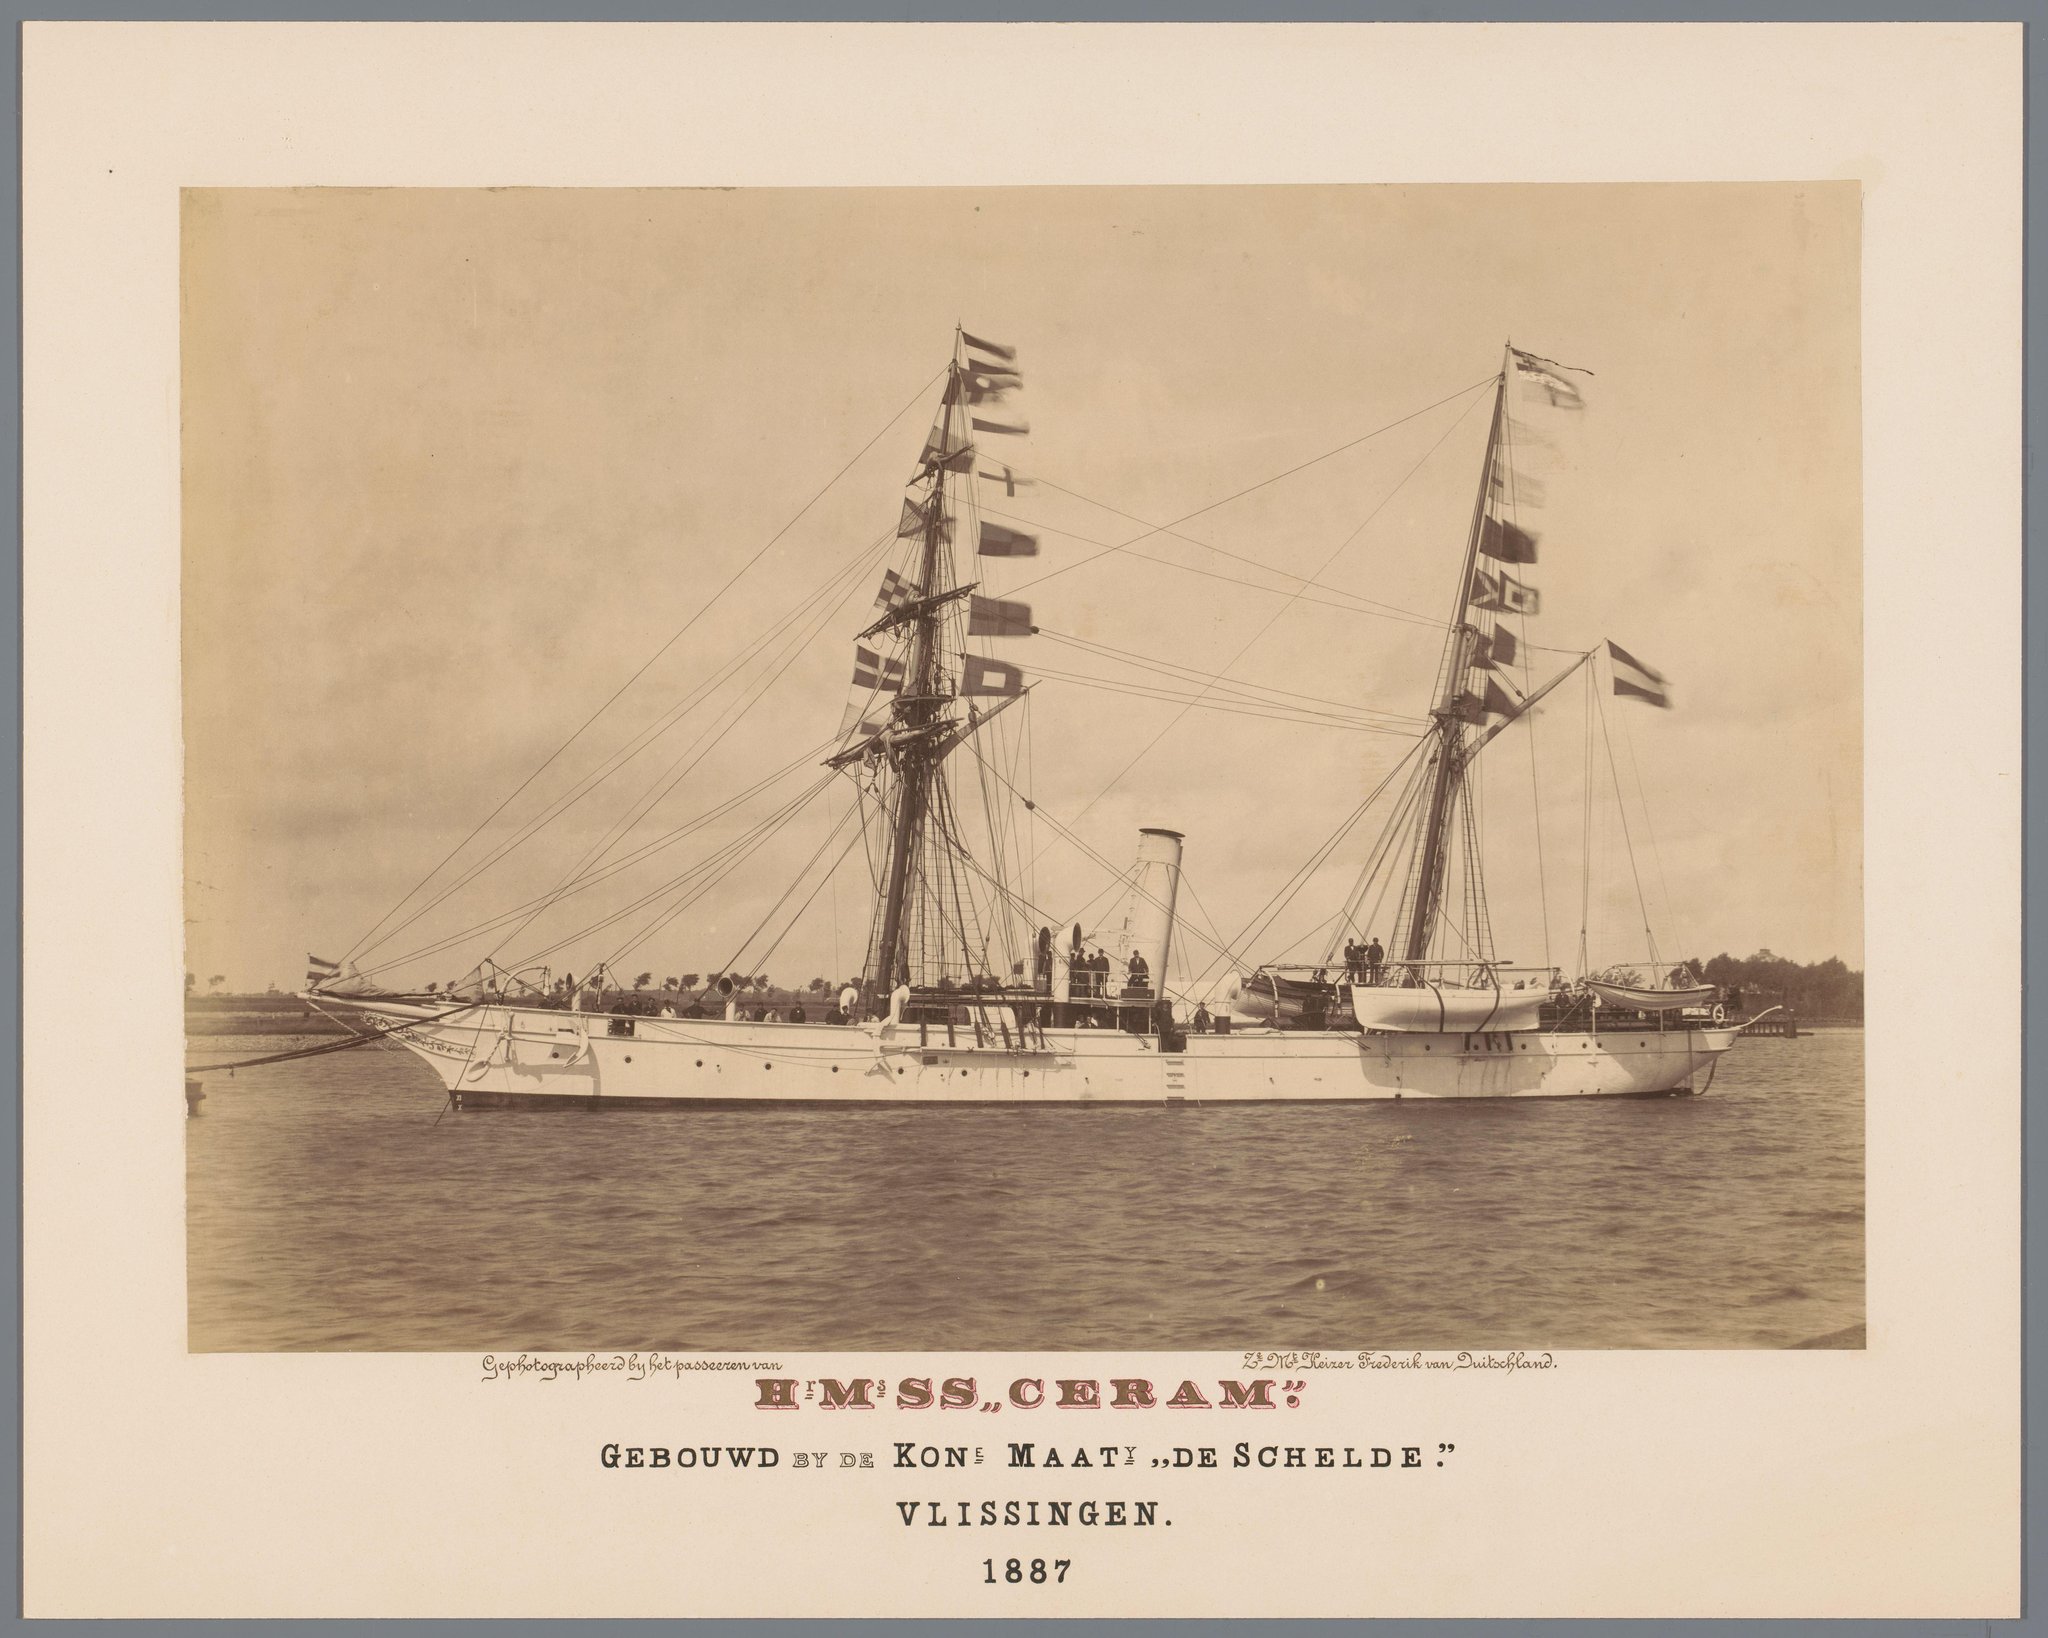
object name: photograph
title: Triple Compound Machine van HrMs SS Ceram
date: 1887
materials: cardboard, paper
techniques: photography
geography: flushing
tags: flushing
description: Foto van een stoomschip, met onderschrift, naam van de machine in rood/geel, rest in zwart. Opschrift; o.: 'Vervaardigd door de Koninklijke Maatschapij "De Schelde".